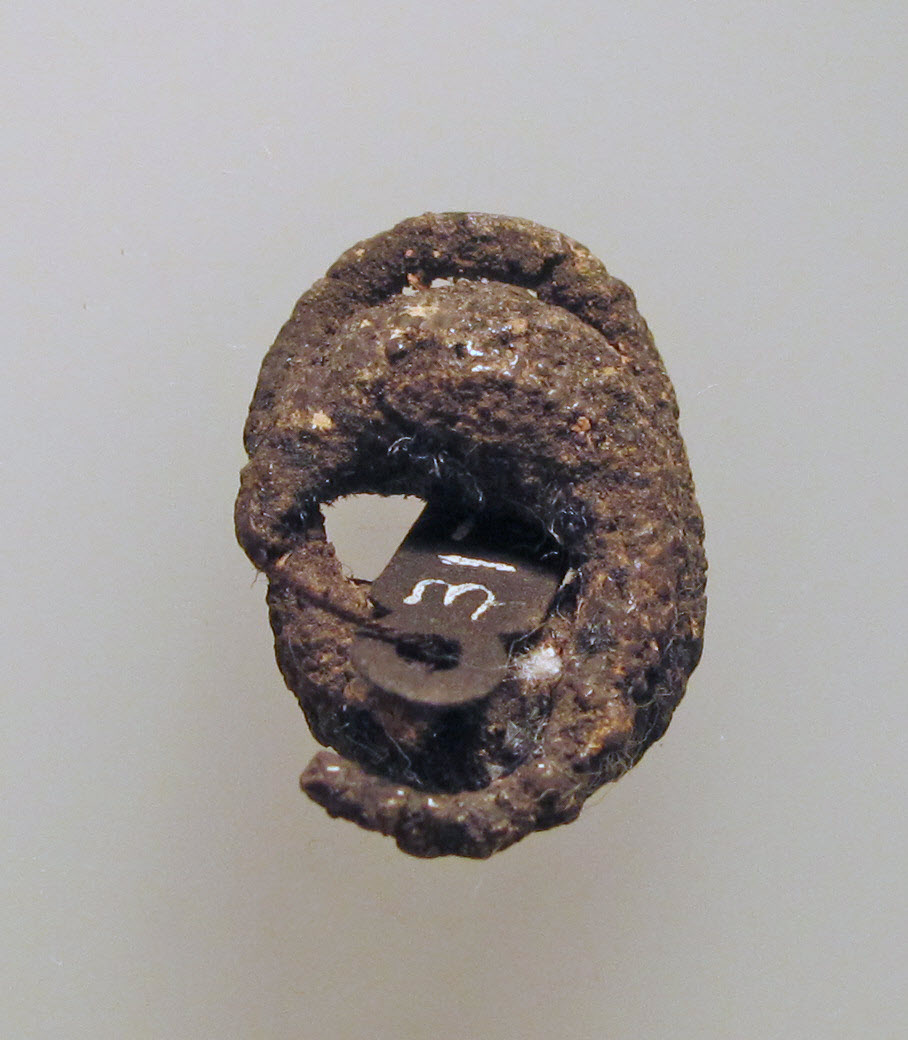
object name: earring corroded together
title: Silver earrings corroded together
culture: cypriot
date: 3900 BCE-100 CE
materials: silver